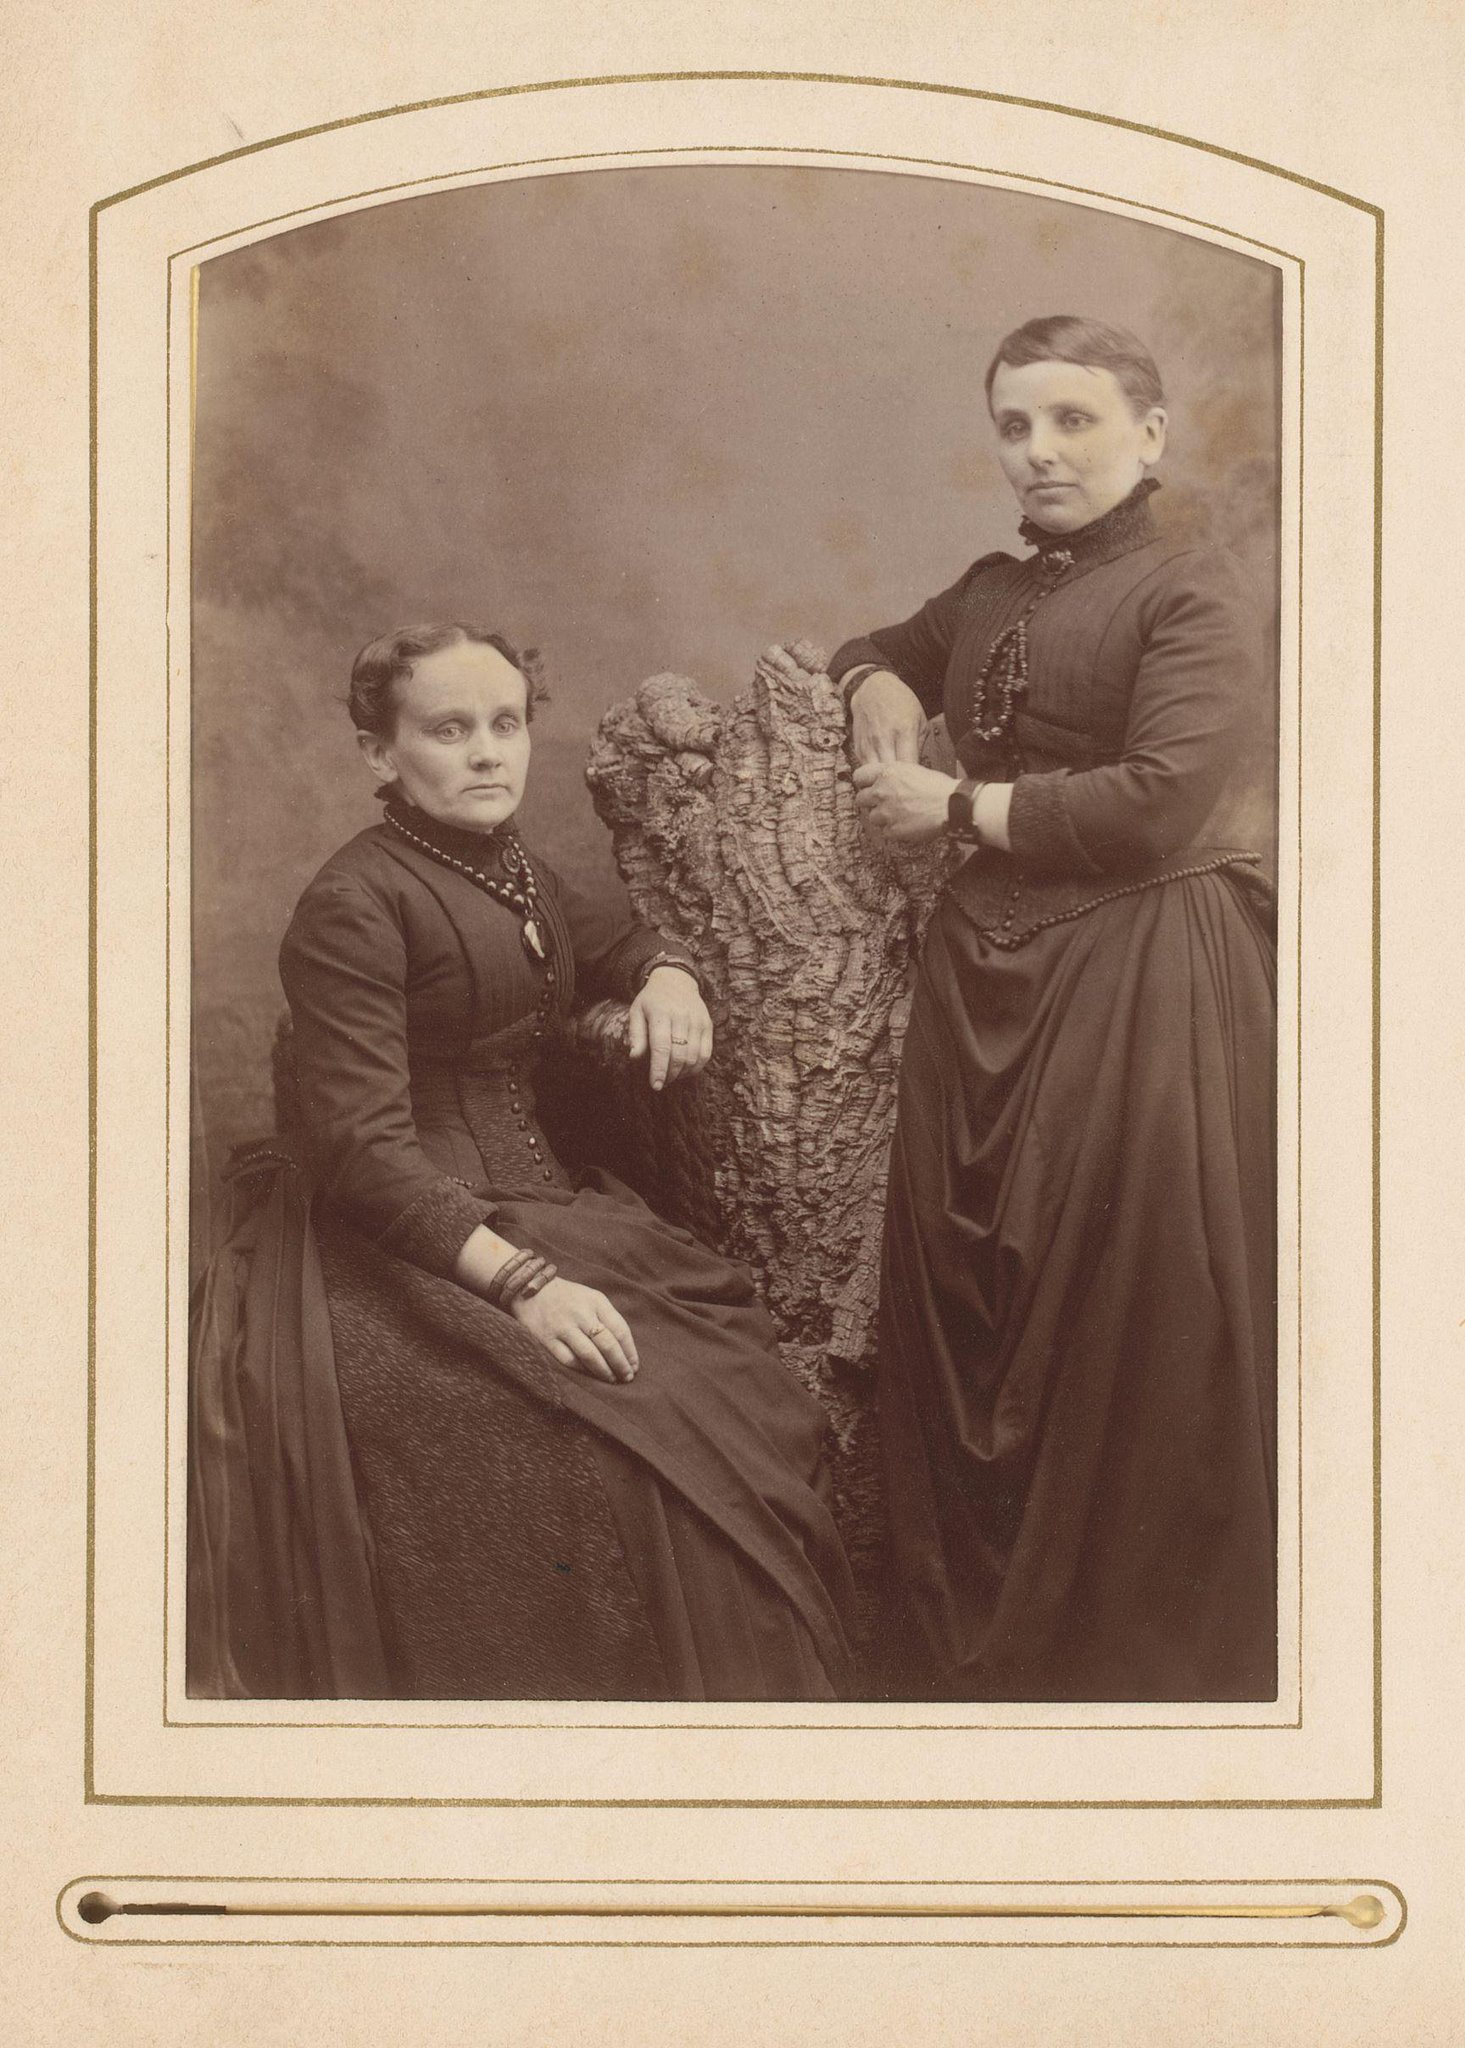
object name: album leaf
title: Portret van twee vrouwen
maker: Anonymous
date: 1860-1900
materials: cardboard, photographic support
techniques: albumen print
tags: adult woman, historical persons